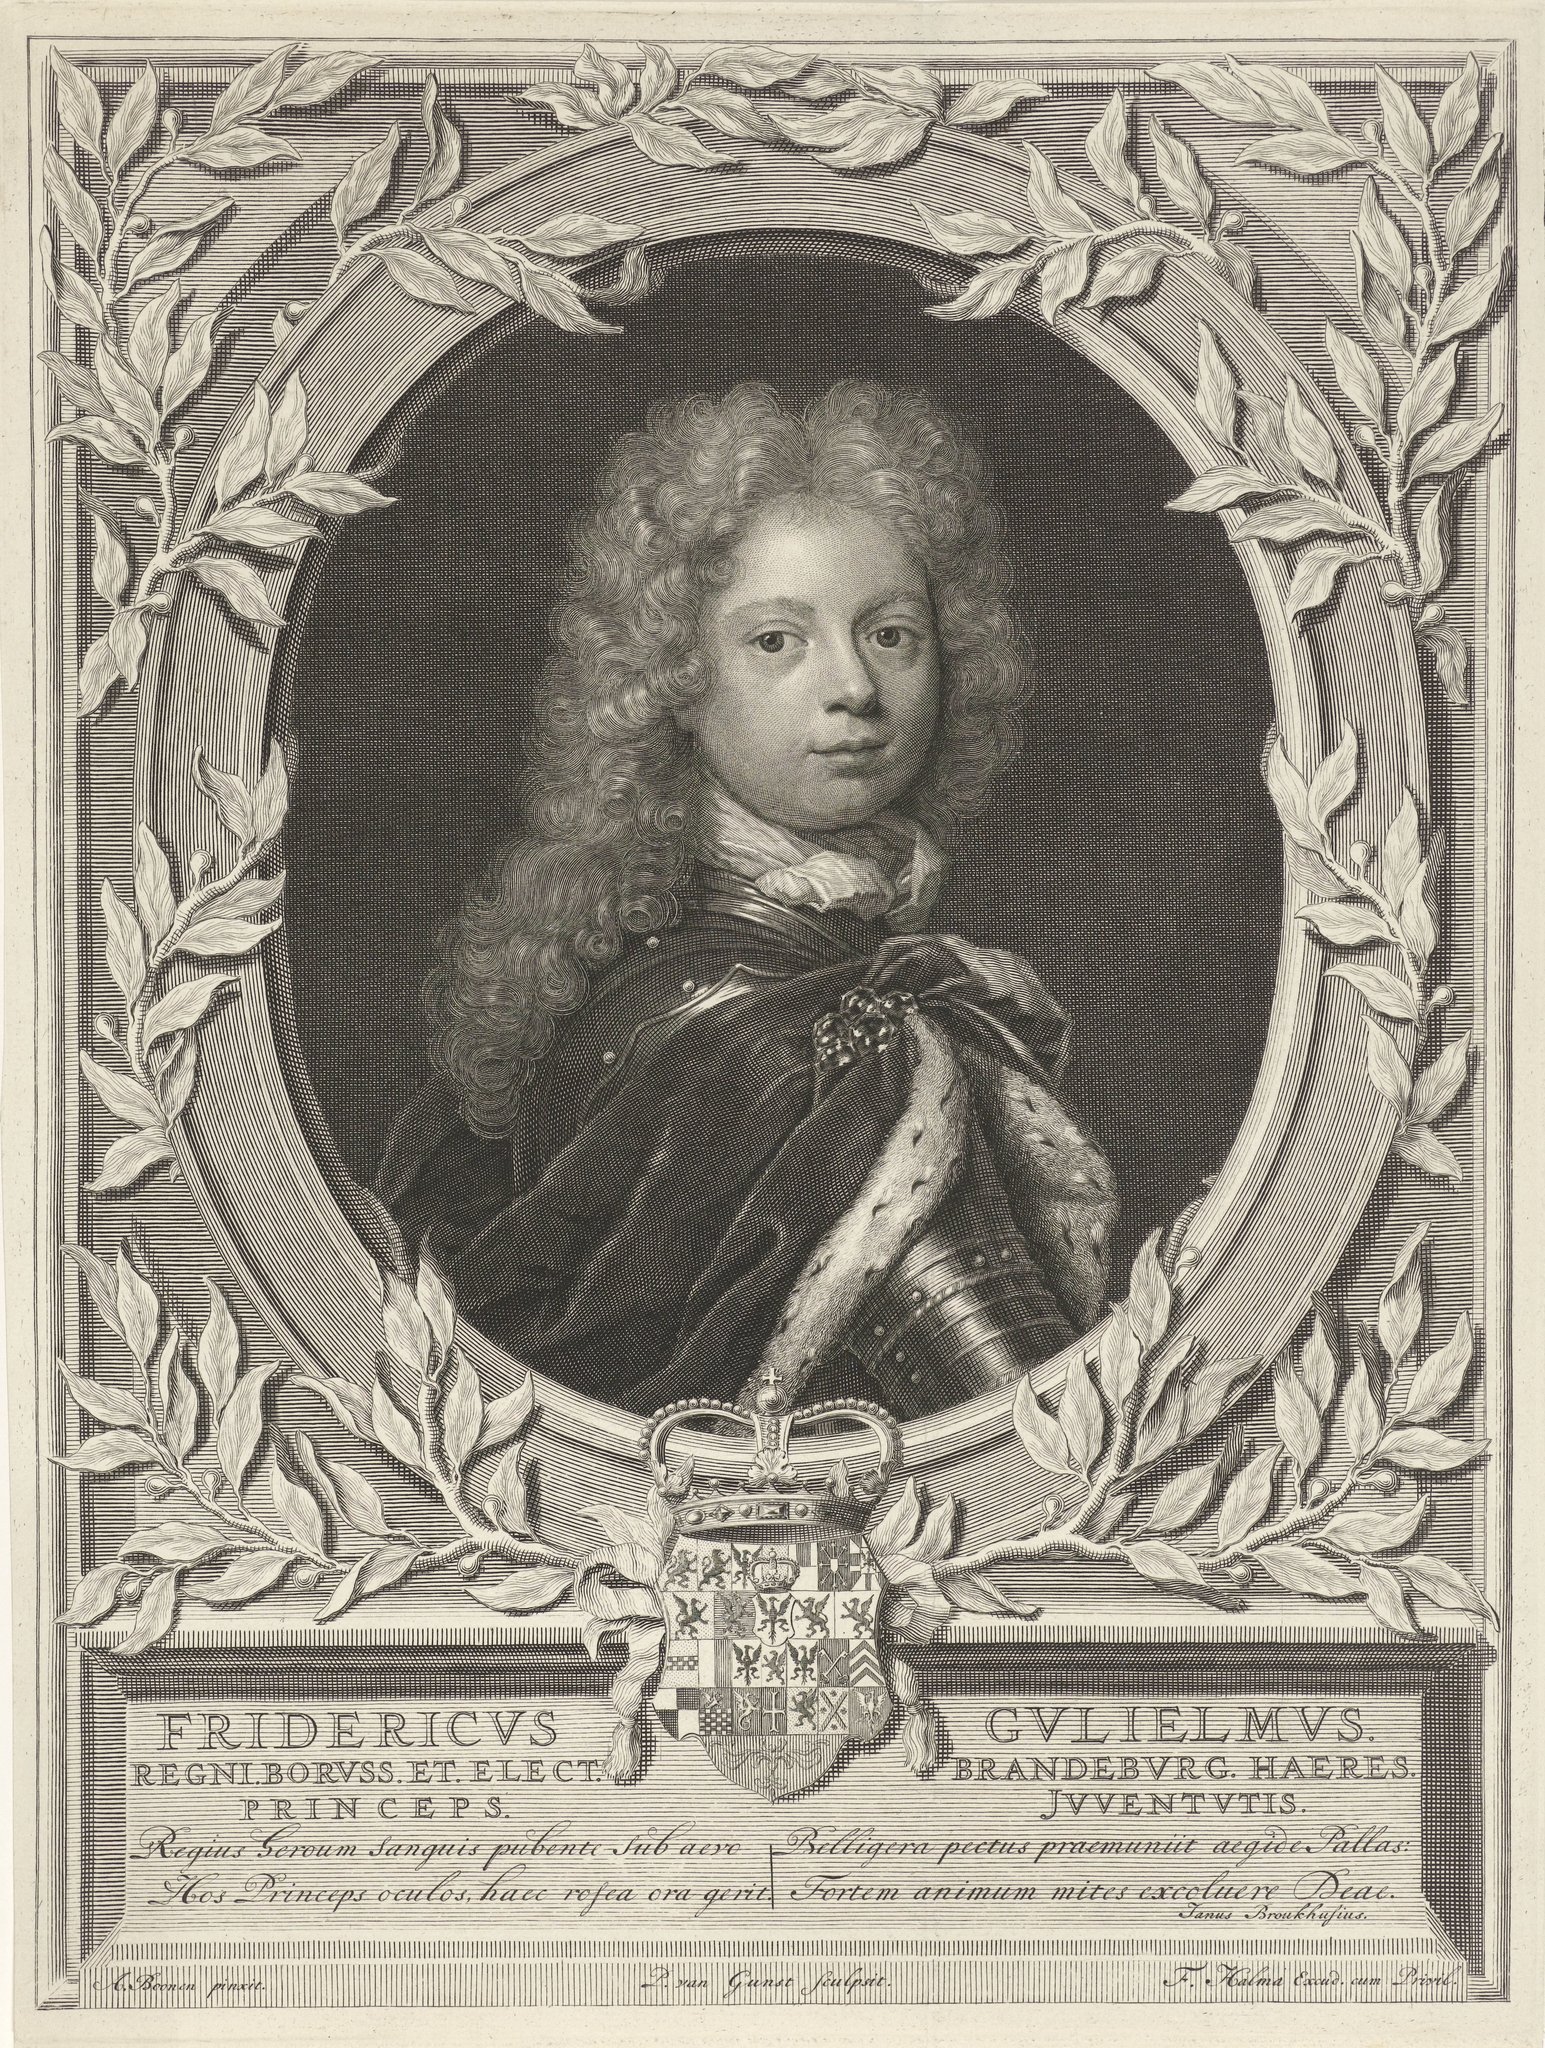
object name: print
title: Portret van Frederik Willem I, koning van Pruisen als kroonprins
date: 1700-1713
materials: paper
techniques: engraving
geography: amsterdam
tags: berlin, frederik willem i koning van pruisen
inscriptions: collector's mark: Lugt 2228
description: Frederik Willem I, koning van Pruisen als kroonprins van Pruisen. Onder het portret zijn wapenschild.